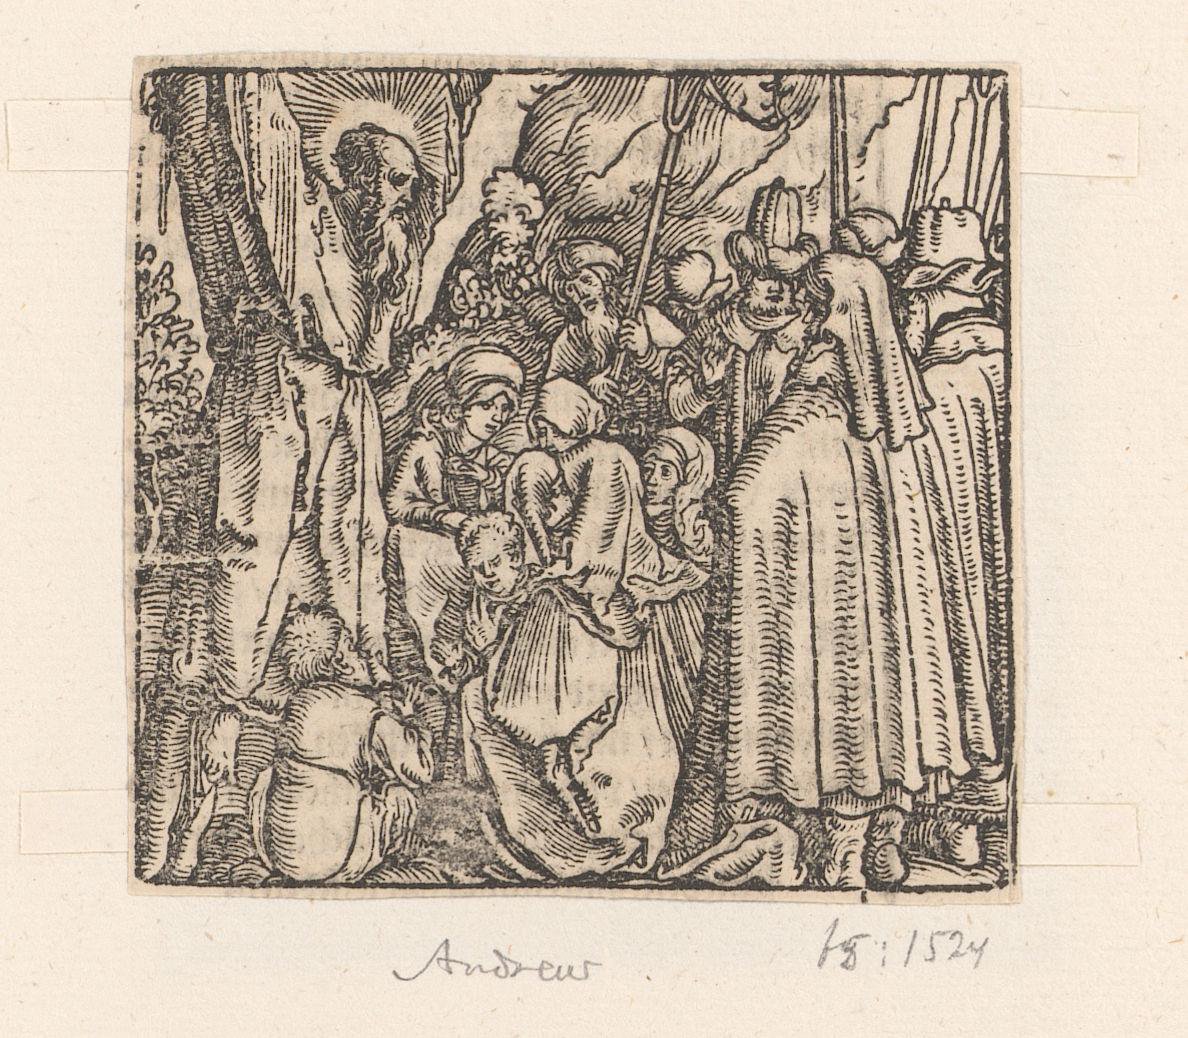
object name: album leaf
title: Martelaarschap van Andreas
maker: Anonymous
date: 1500-1536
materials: paper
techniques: woodcut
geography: germany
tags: crucifixion of andrew: he is undressed and tied to the cross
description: De apostel Andreas is gekruisigd. Omstanders kijken toe. Prent maakt deel uit van een album.